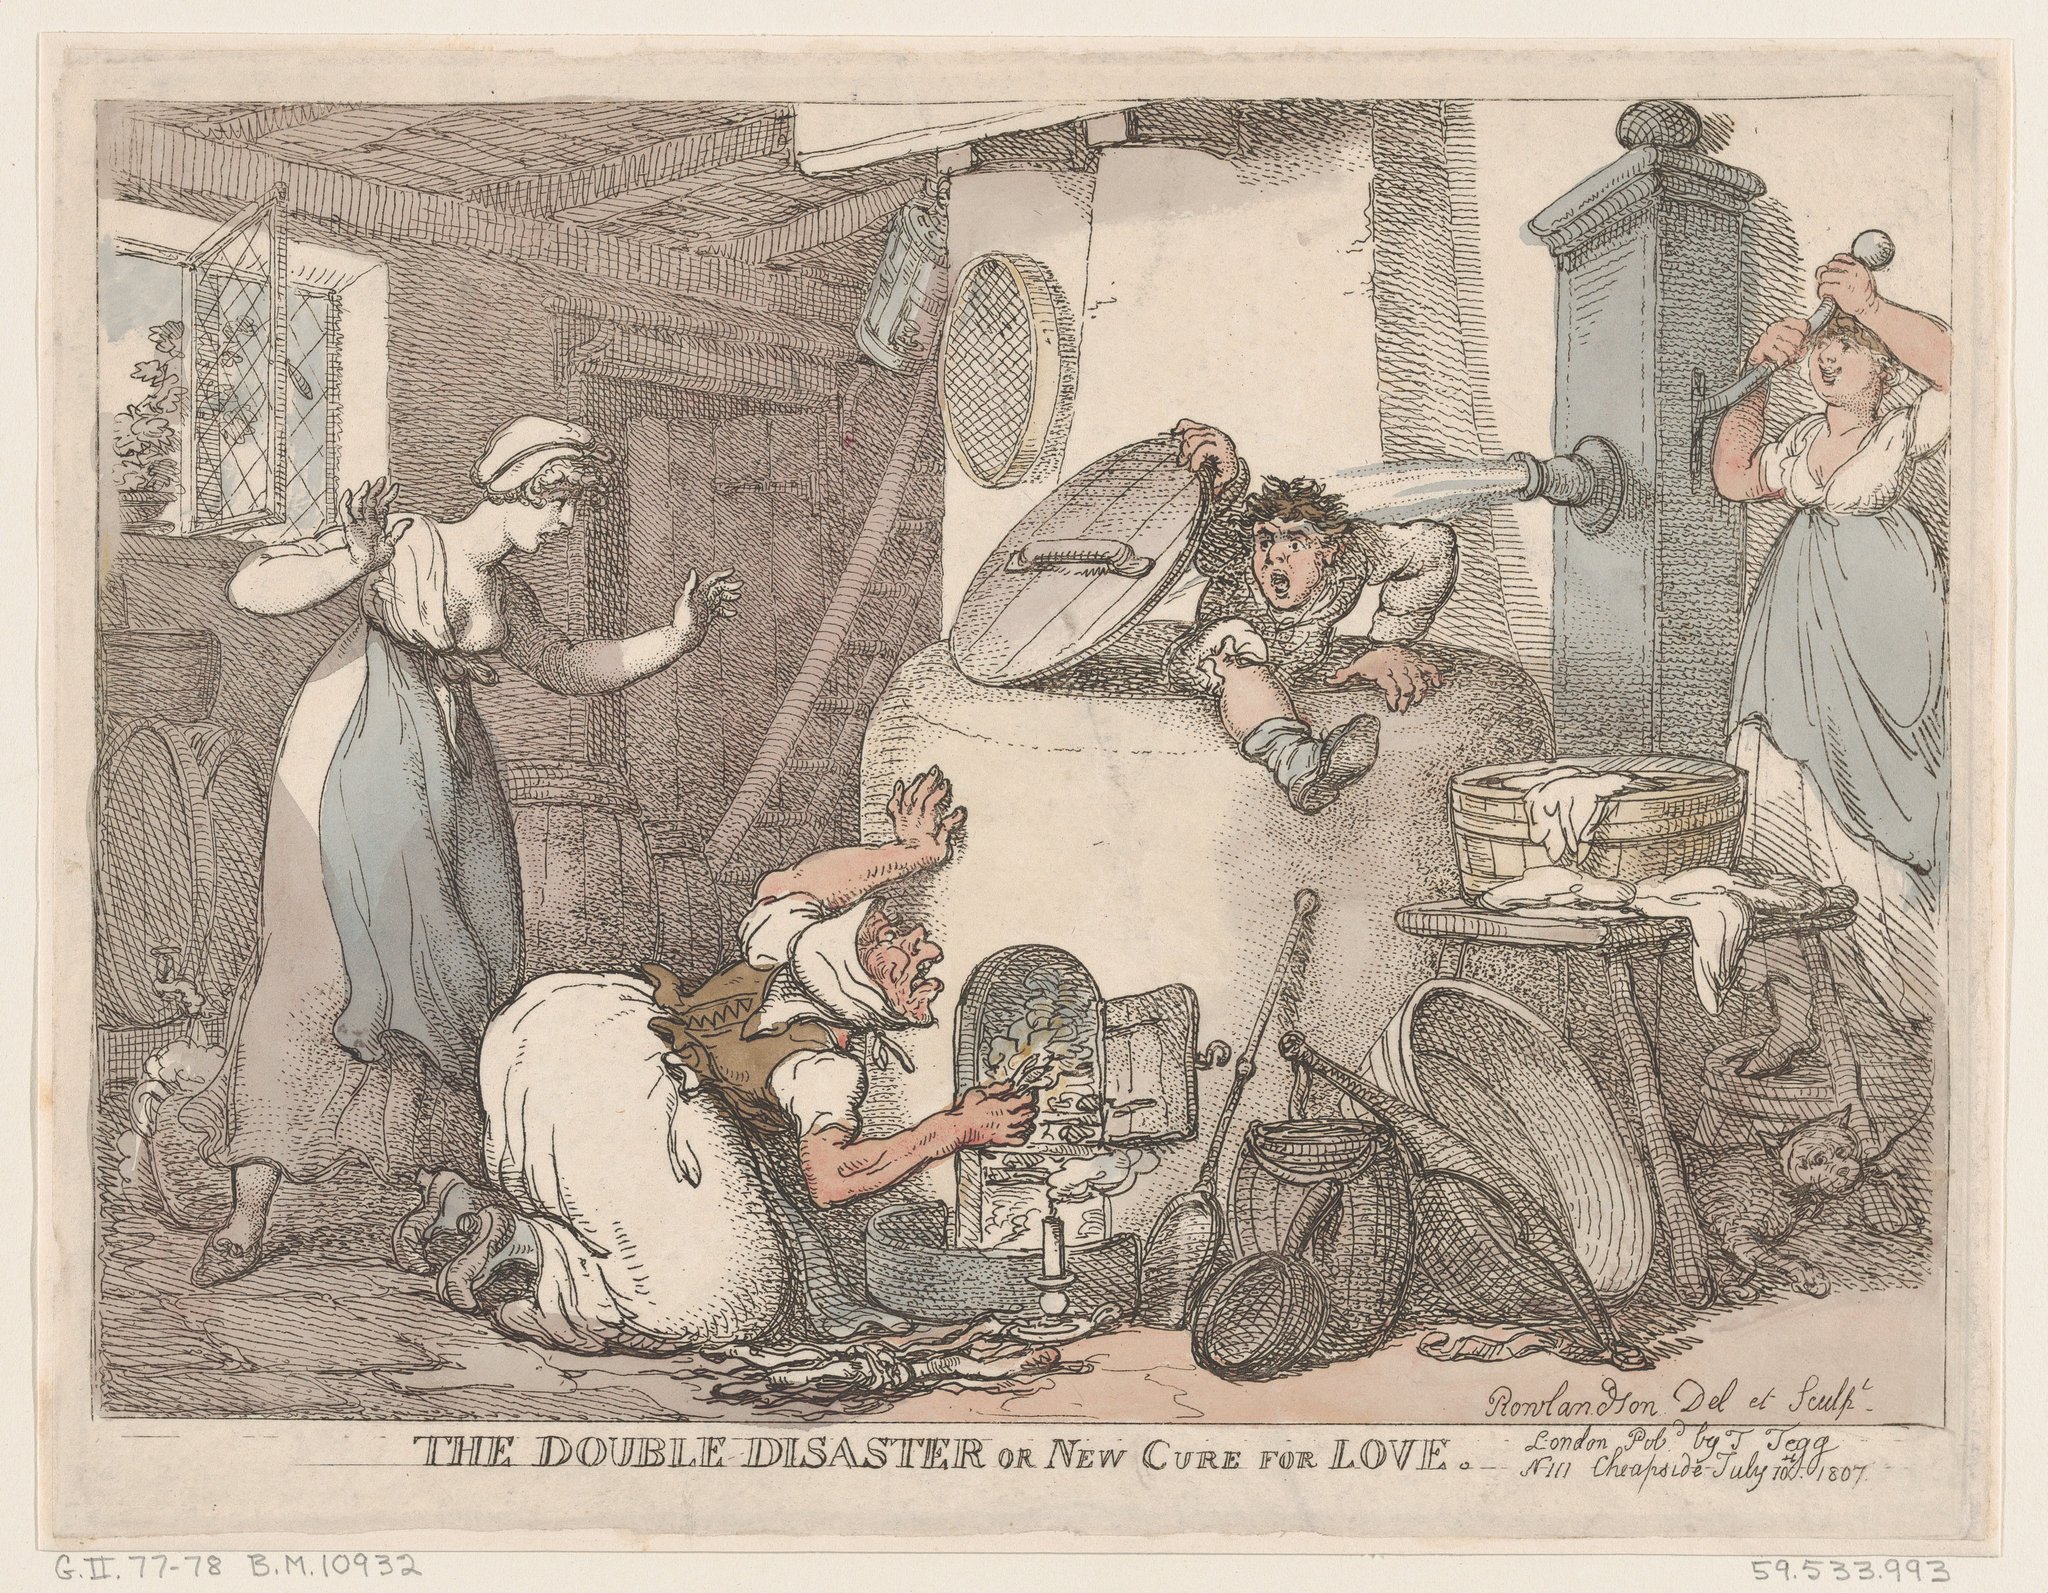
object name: print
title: The Double Disaster, or New Cure for Love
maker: thomas rowlandson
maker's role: artist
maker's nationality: british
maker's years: 1757-1827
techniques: etching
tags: men,women,working